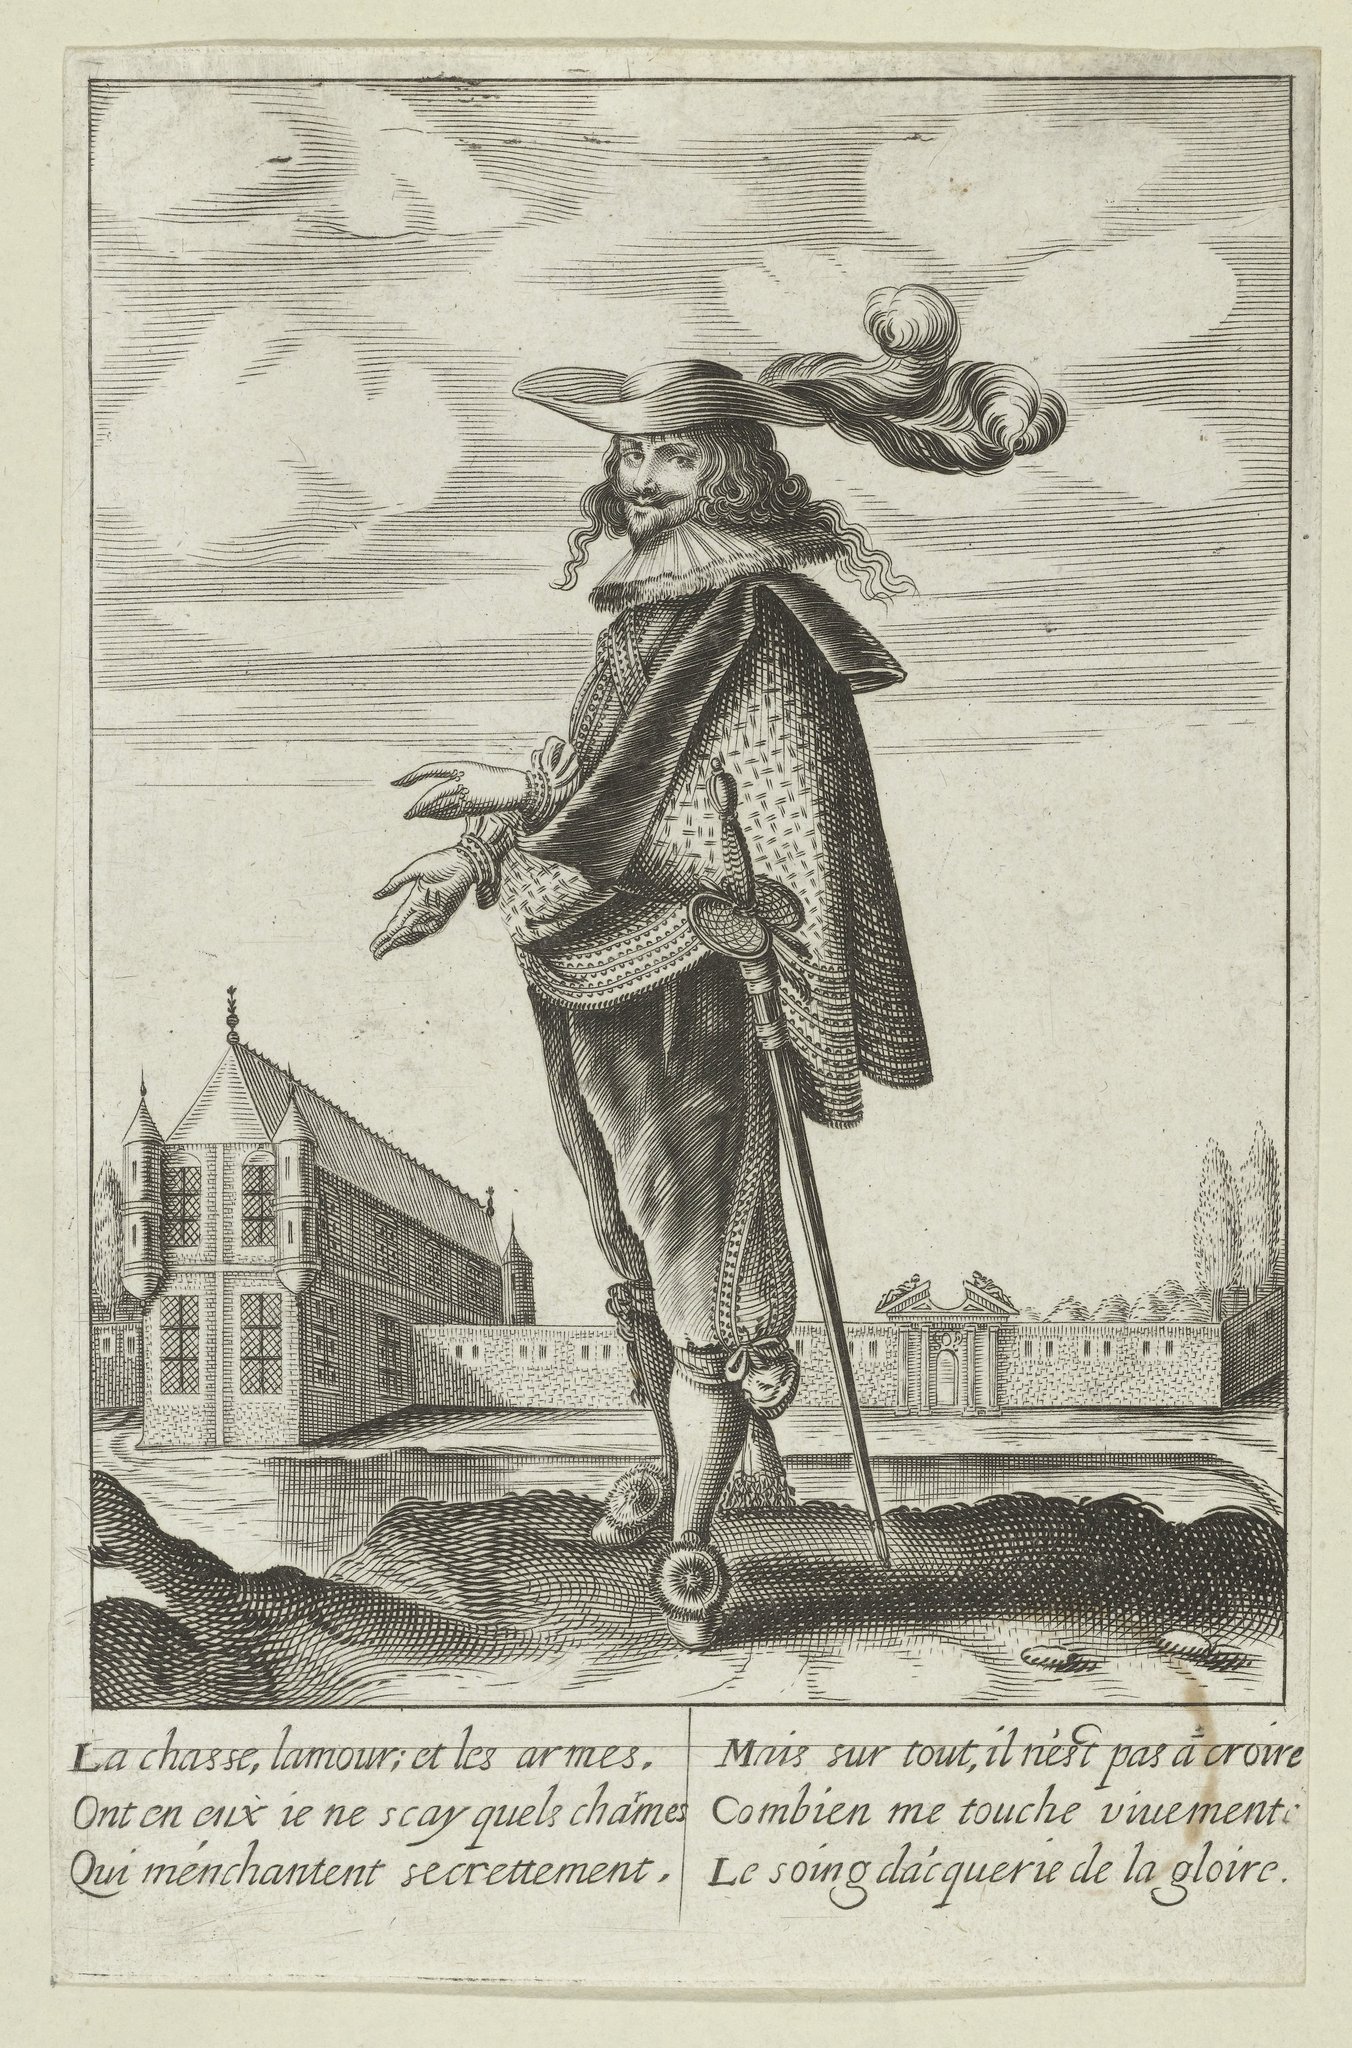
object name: costume print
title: Diversitez d'Habillemens a la mode (...)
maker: isaac briot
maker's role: print maker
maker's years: 1585-1670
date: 1630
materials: paper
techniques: engraving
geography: france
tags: ornamental parts of clothing (+ men's clothes), coat (+ men's clothes), head-gear: hat (+ men's clothes), shoes, sandals (+ men's clothes), neck-gear: collar (+ men's clothes), trousers, breeches, etc. (breeches) (+ men's clothes), head-gear: hat (+ feathers used for clothes)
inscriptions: caption: ‘La chasse, l'amour et les armes, / Ont en eux ie ne scay quels charmes / Qui m'enchantent secrettement, / Mair sur tout, il n'est pas a croire / Combien me touche vivement / Le soing d acquerie de la gloire.’, collector's mark: Lugt 240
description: Maakt deel uit van een serie van minstens twaalf prenten van kostuums, getiteld: "Diversitez d'Habillemens a la mode; Naifuement portraits sur la differente condition de la Noblesse des Magistrats, et du tiers estat, le tout dédié a Messire Nicolas le Iay Chevalier Seigneur de Tilly, de Maison rouge de St Fargeau et de Villiers Con en sa cour de Parlement". De serie werd uitgegeven door Iacqueq Honeruogt in Parijs, ca. 1630.